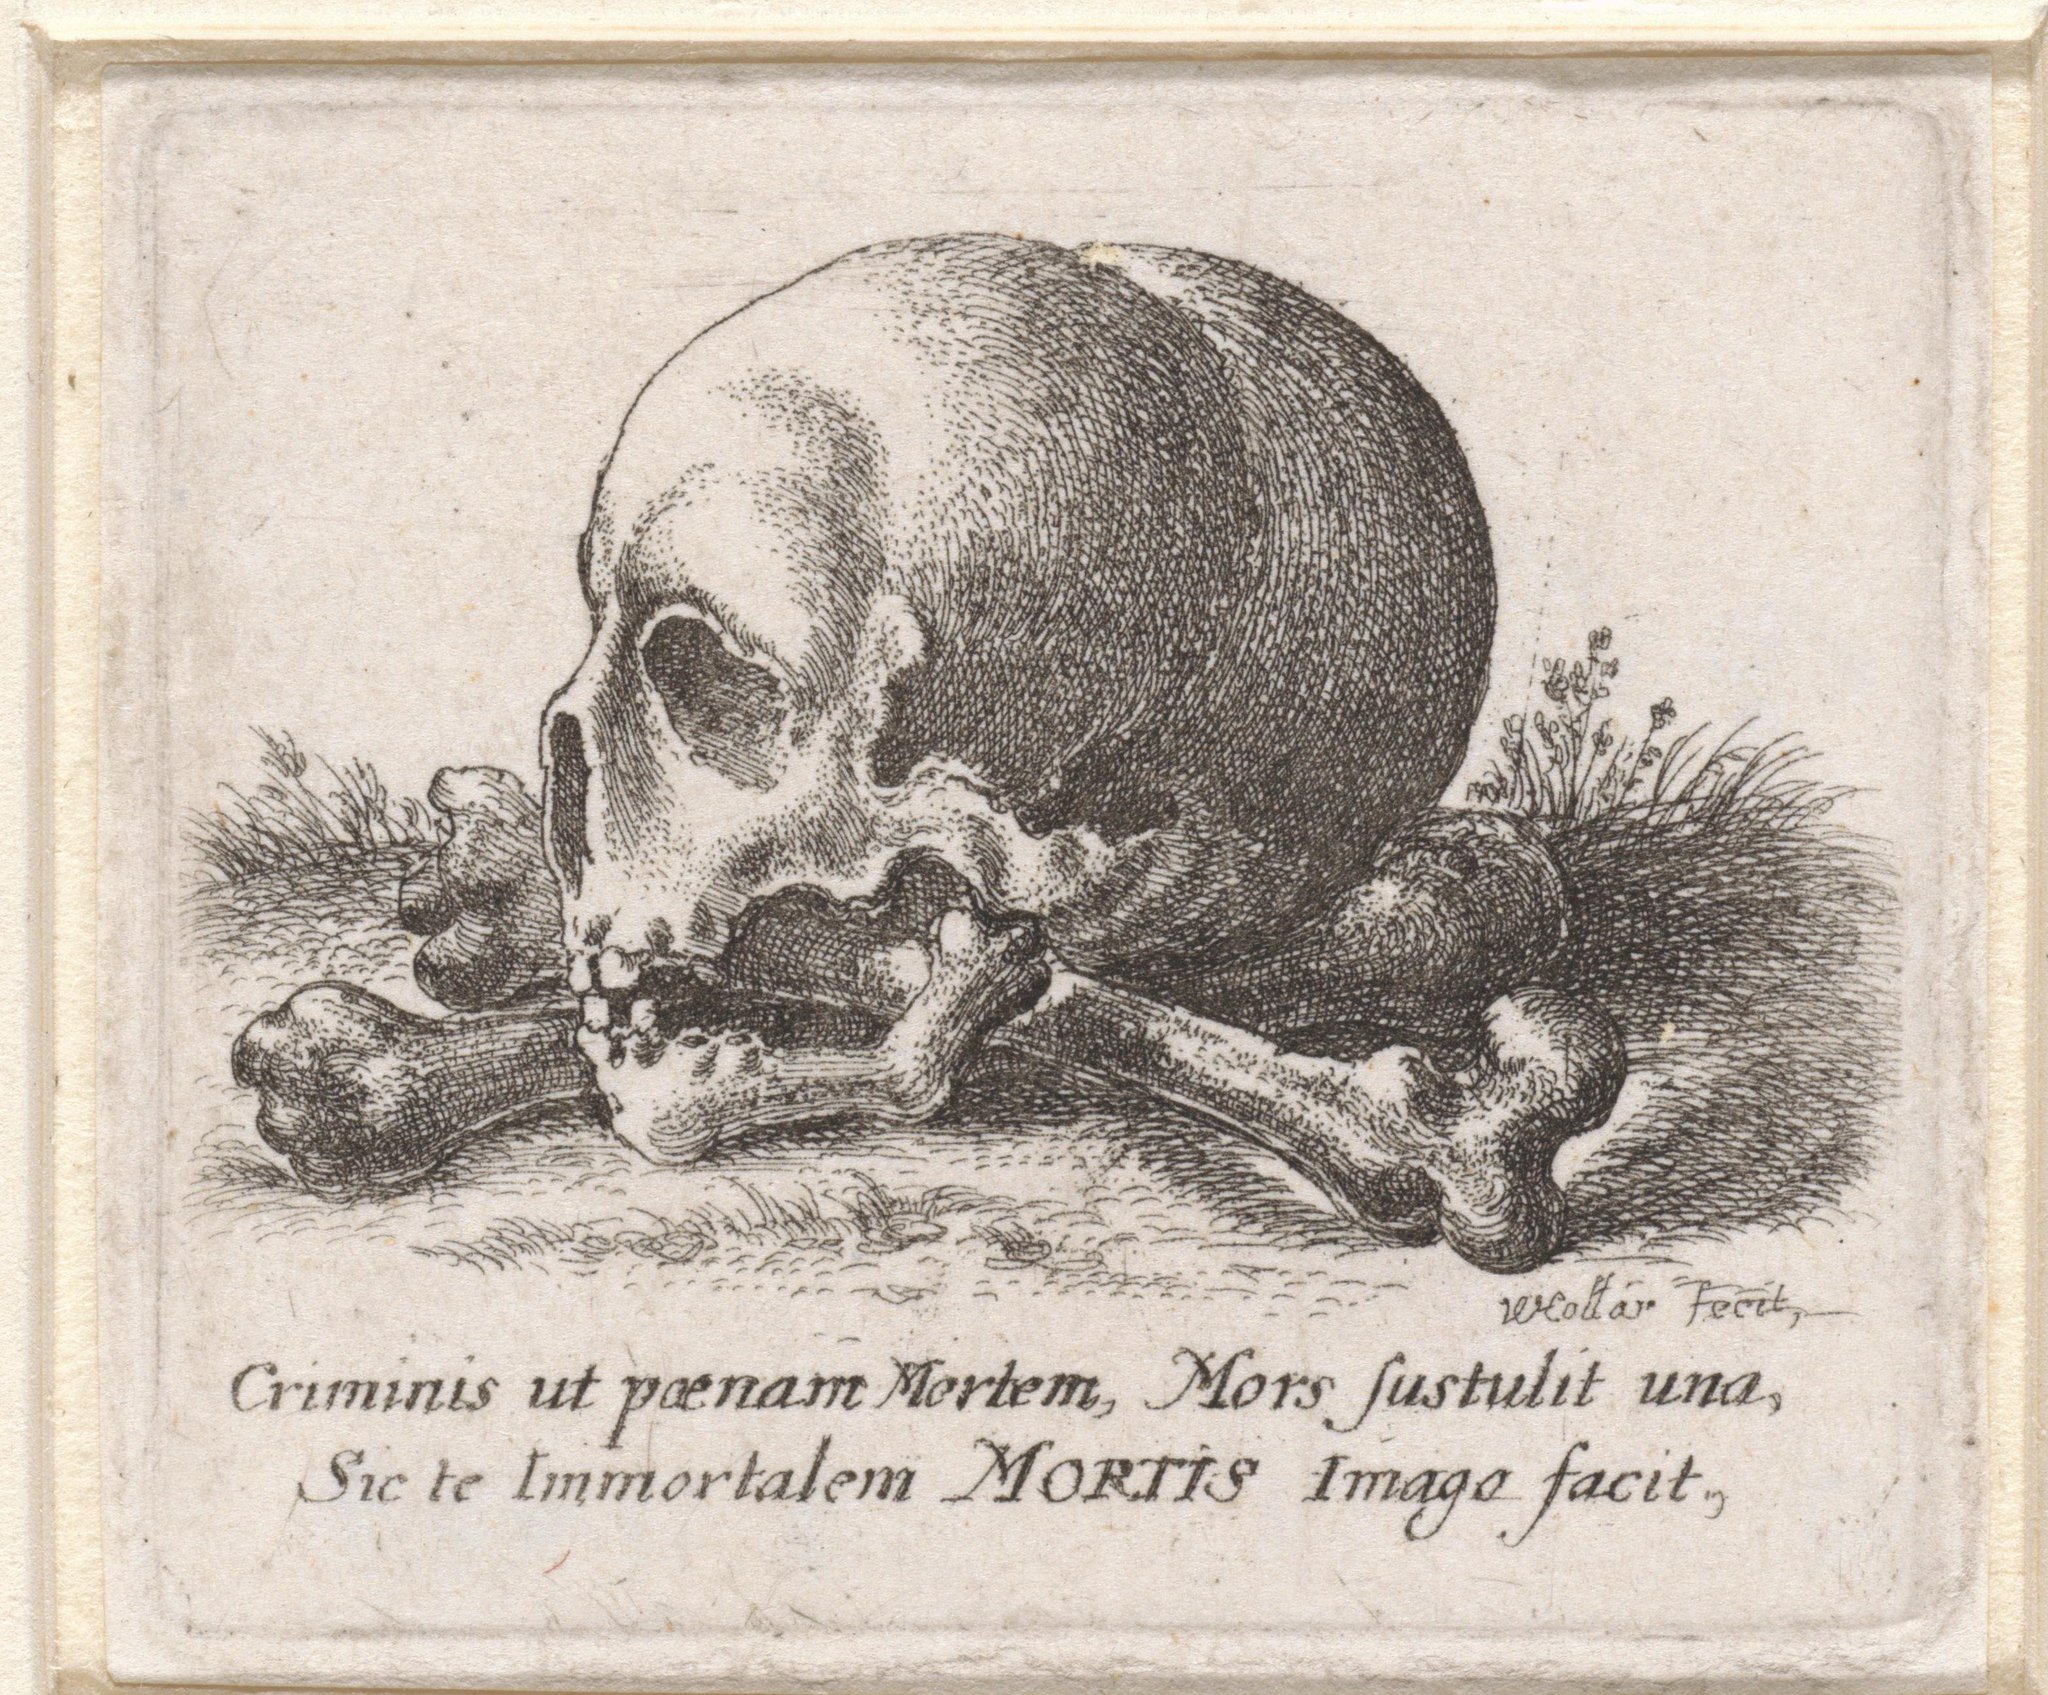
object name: print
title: Schedel en beenderen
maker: wenceslaus hollar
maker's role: draughtsman, print maker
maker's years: 1607-1677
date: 1652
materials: paper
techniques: etching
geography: antwerp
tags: (human) skull, bones in general (human body)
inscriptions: collector's mark: Lugt 240